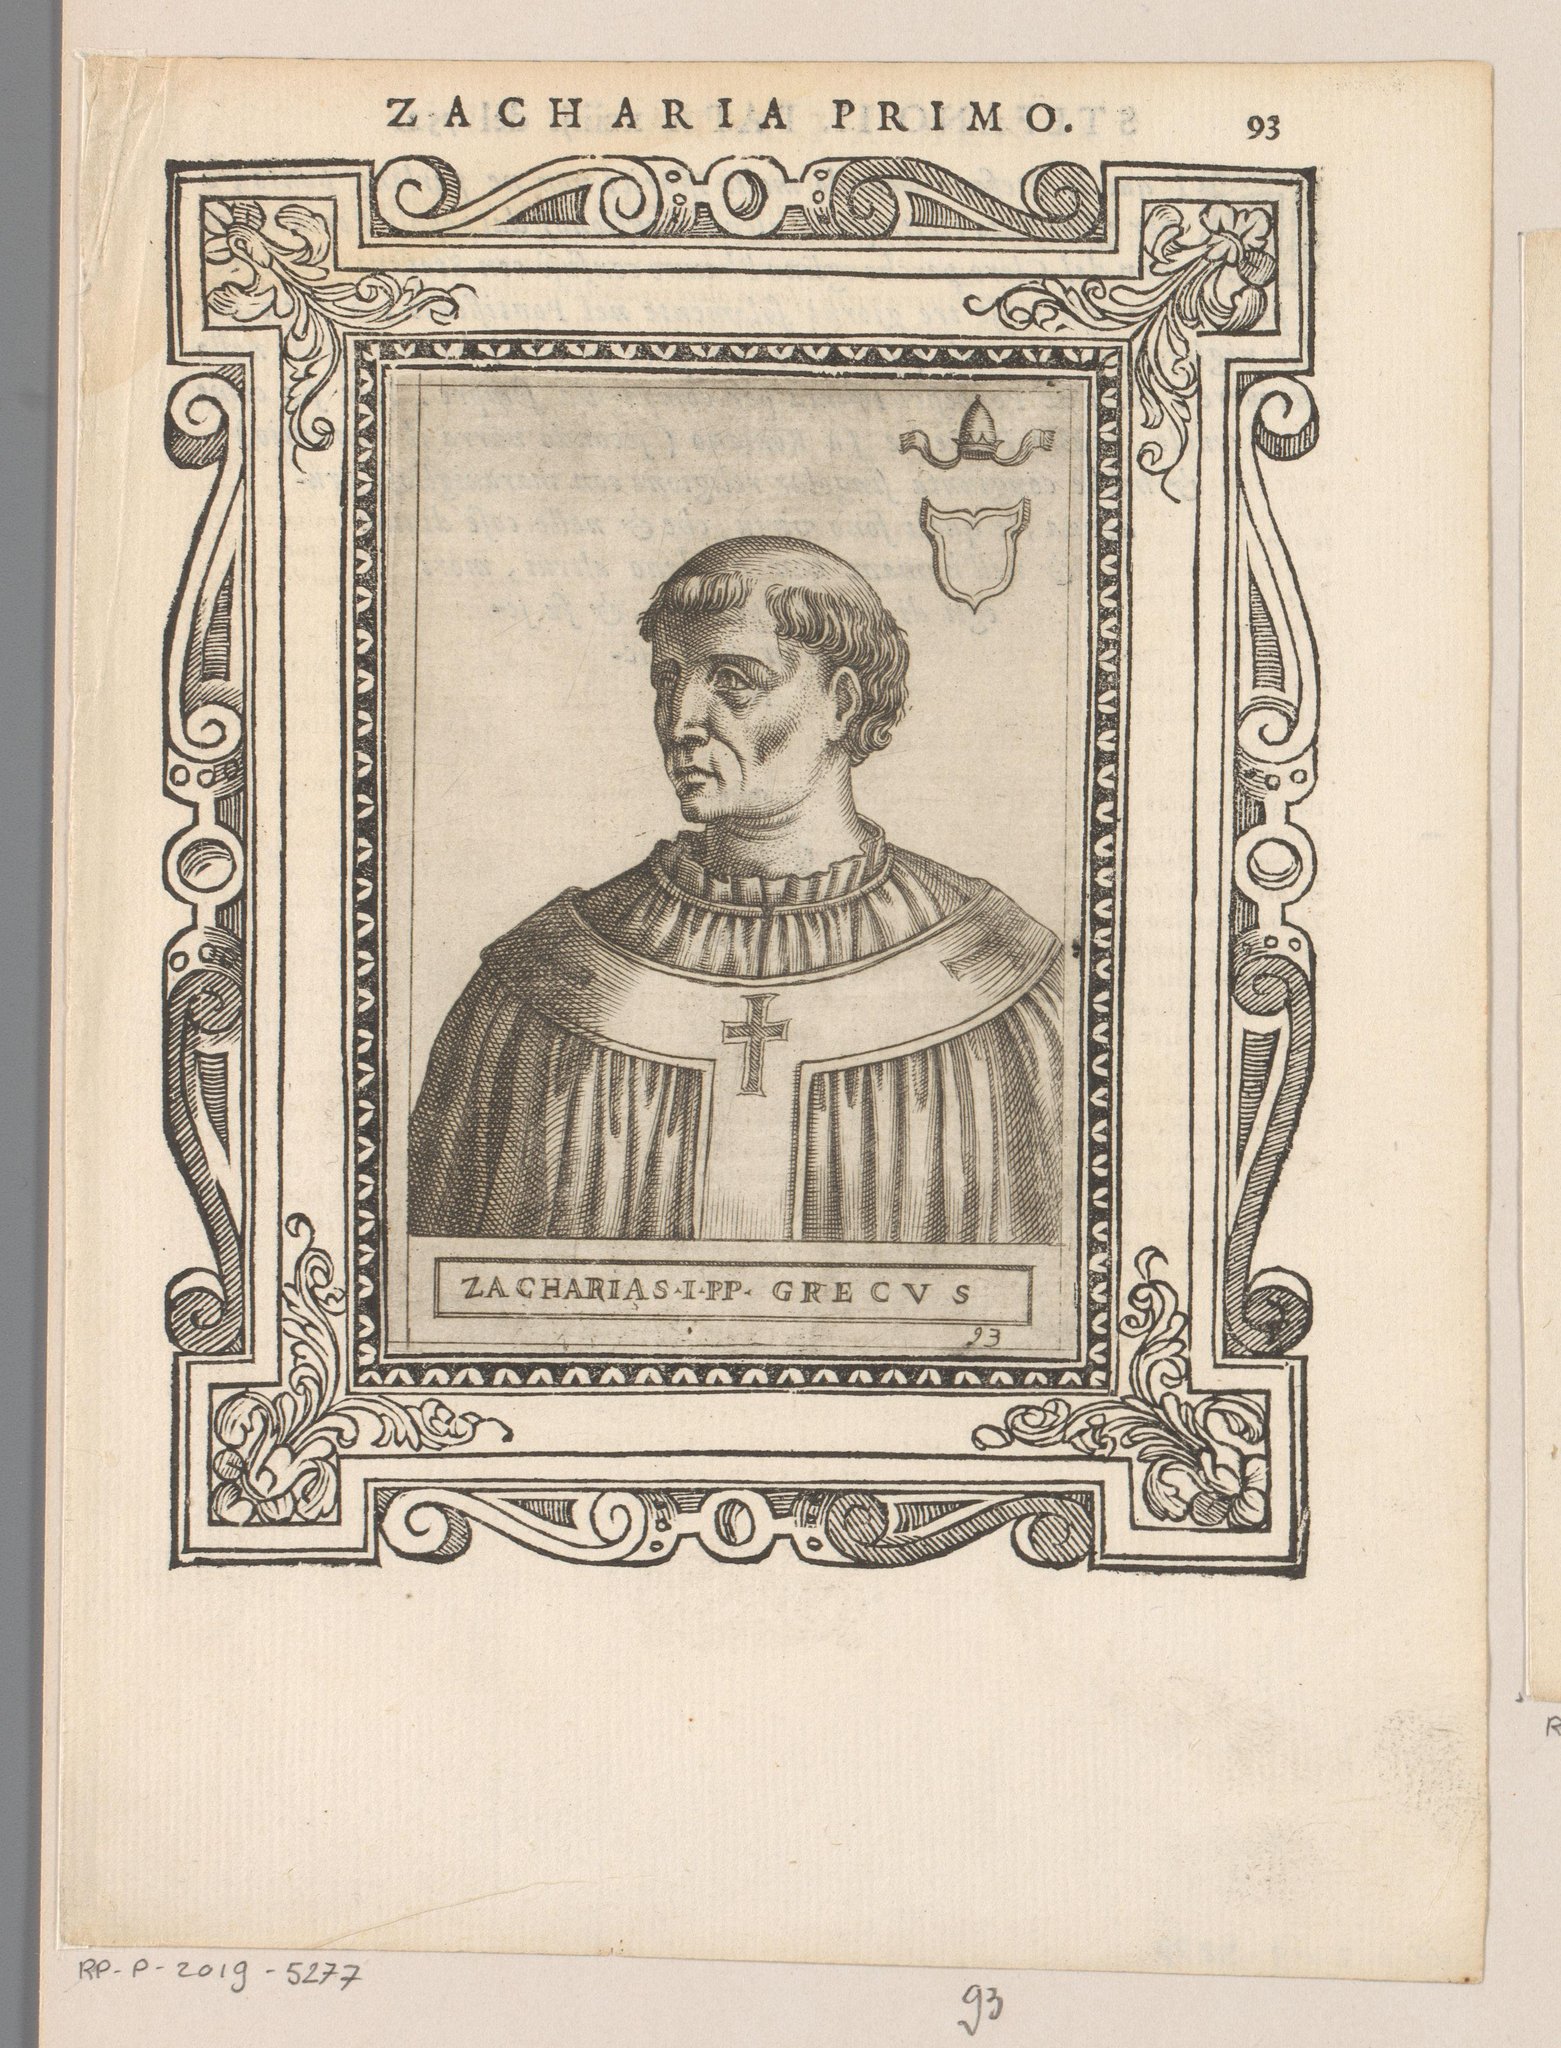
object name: book illustration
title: Portret van paus Zacharias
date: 1587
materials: paper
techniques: engraving, letterpress printing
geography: rome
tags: historical persons, pope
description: Prent uit: Ciccarelli, Antonio. Le vite de Pontefici di Antonio Ciccarelli (...). Rome: Domenico Basa, 1587. Prent voor het eerst verschenen in: Cavalieri, Giovanni Battista de'. Pontificum romanorum effigies (...). Rome: Domenico Basa en Francesco Zanetti, 1580. Prent ook gebruikt in latere publicaties.